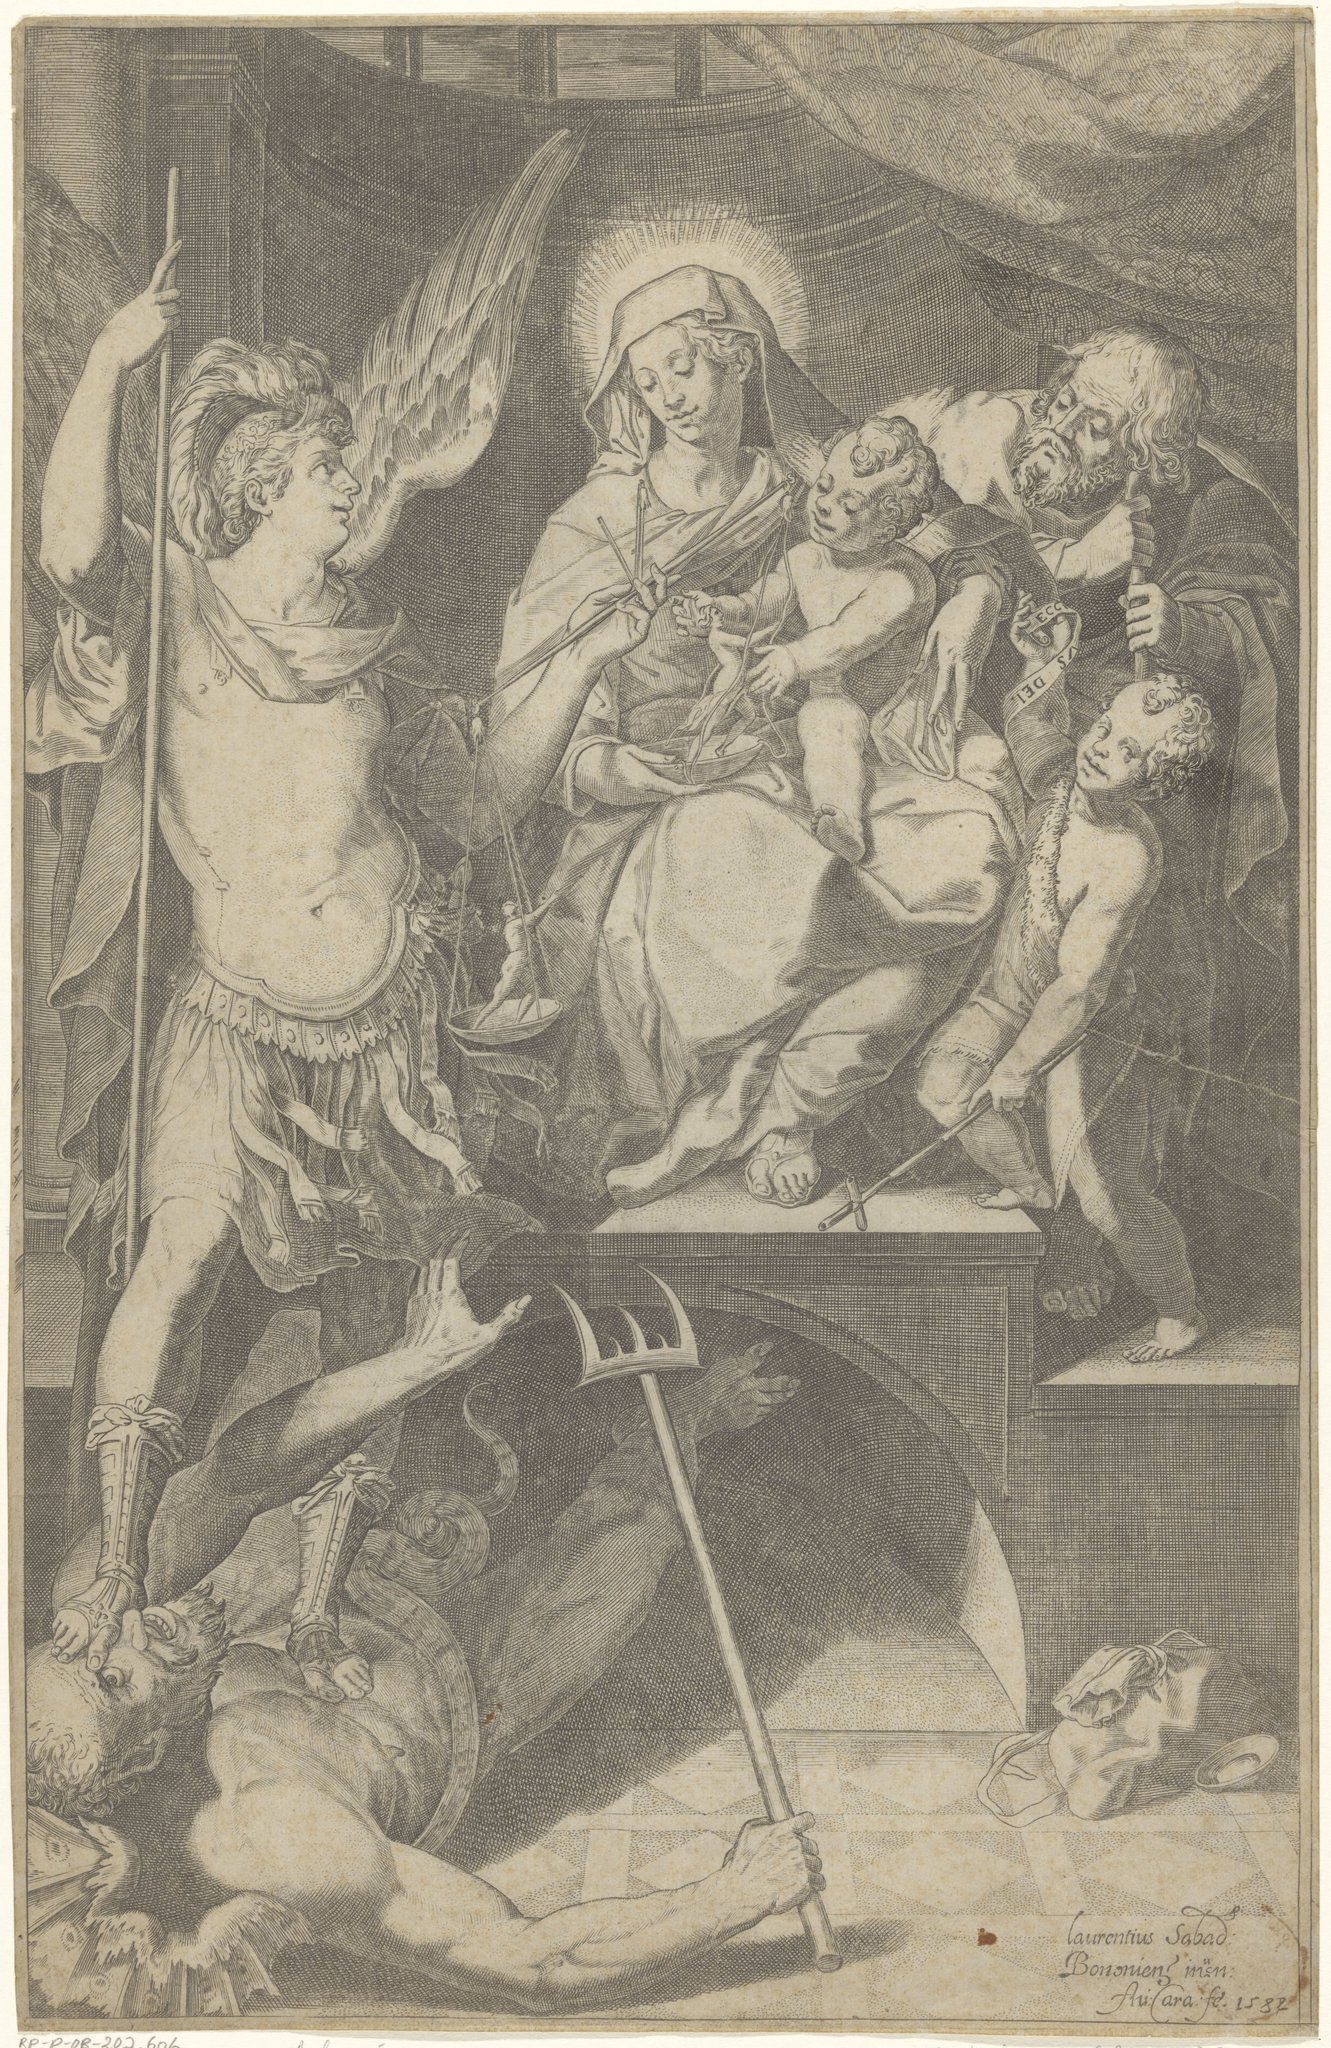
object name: print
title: Heilige Familie met de aartsengel Michaël en de jonge Johannes de Doper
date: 1582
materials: paper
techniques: engraving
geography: bologna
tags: balance, equilibrium, the archangel michael (often in armour with sword or lance), holy family, and derived representations, holy family with john the baptist (as child)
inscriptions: collector's mark: Lugt 240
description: Maria zit met het Christuskind op schoot. Rechts staan Jozef en de jonge Johannes de Doper. Links staat de aartsengel Michaël triomfantelijk op een overwonnen duivel. Michaël heeft in zijn ene hand een speer en in zijn andere hand een weegschaal. Het Christuskind grijpt naar de weegschaal.